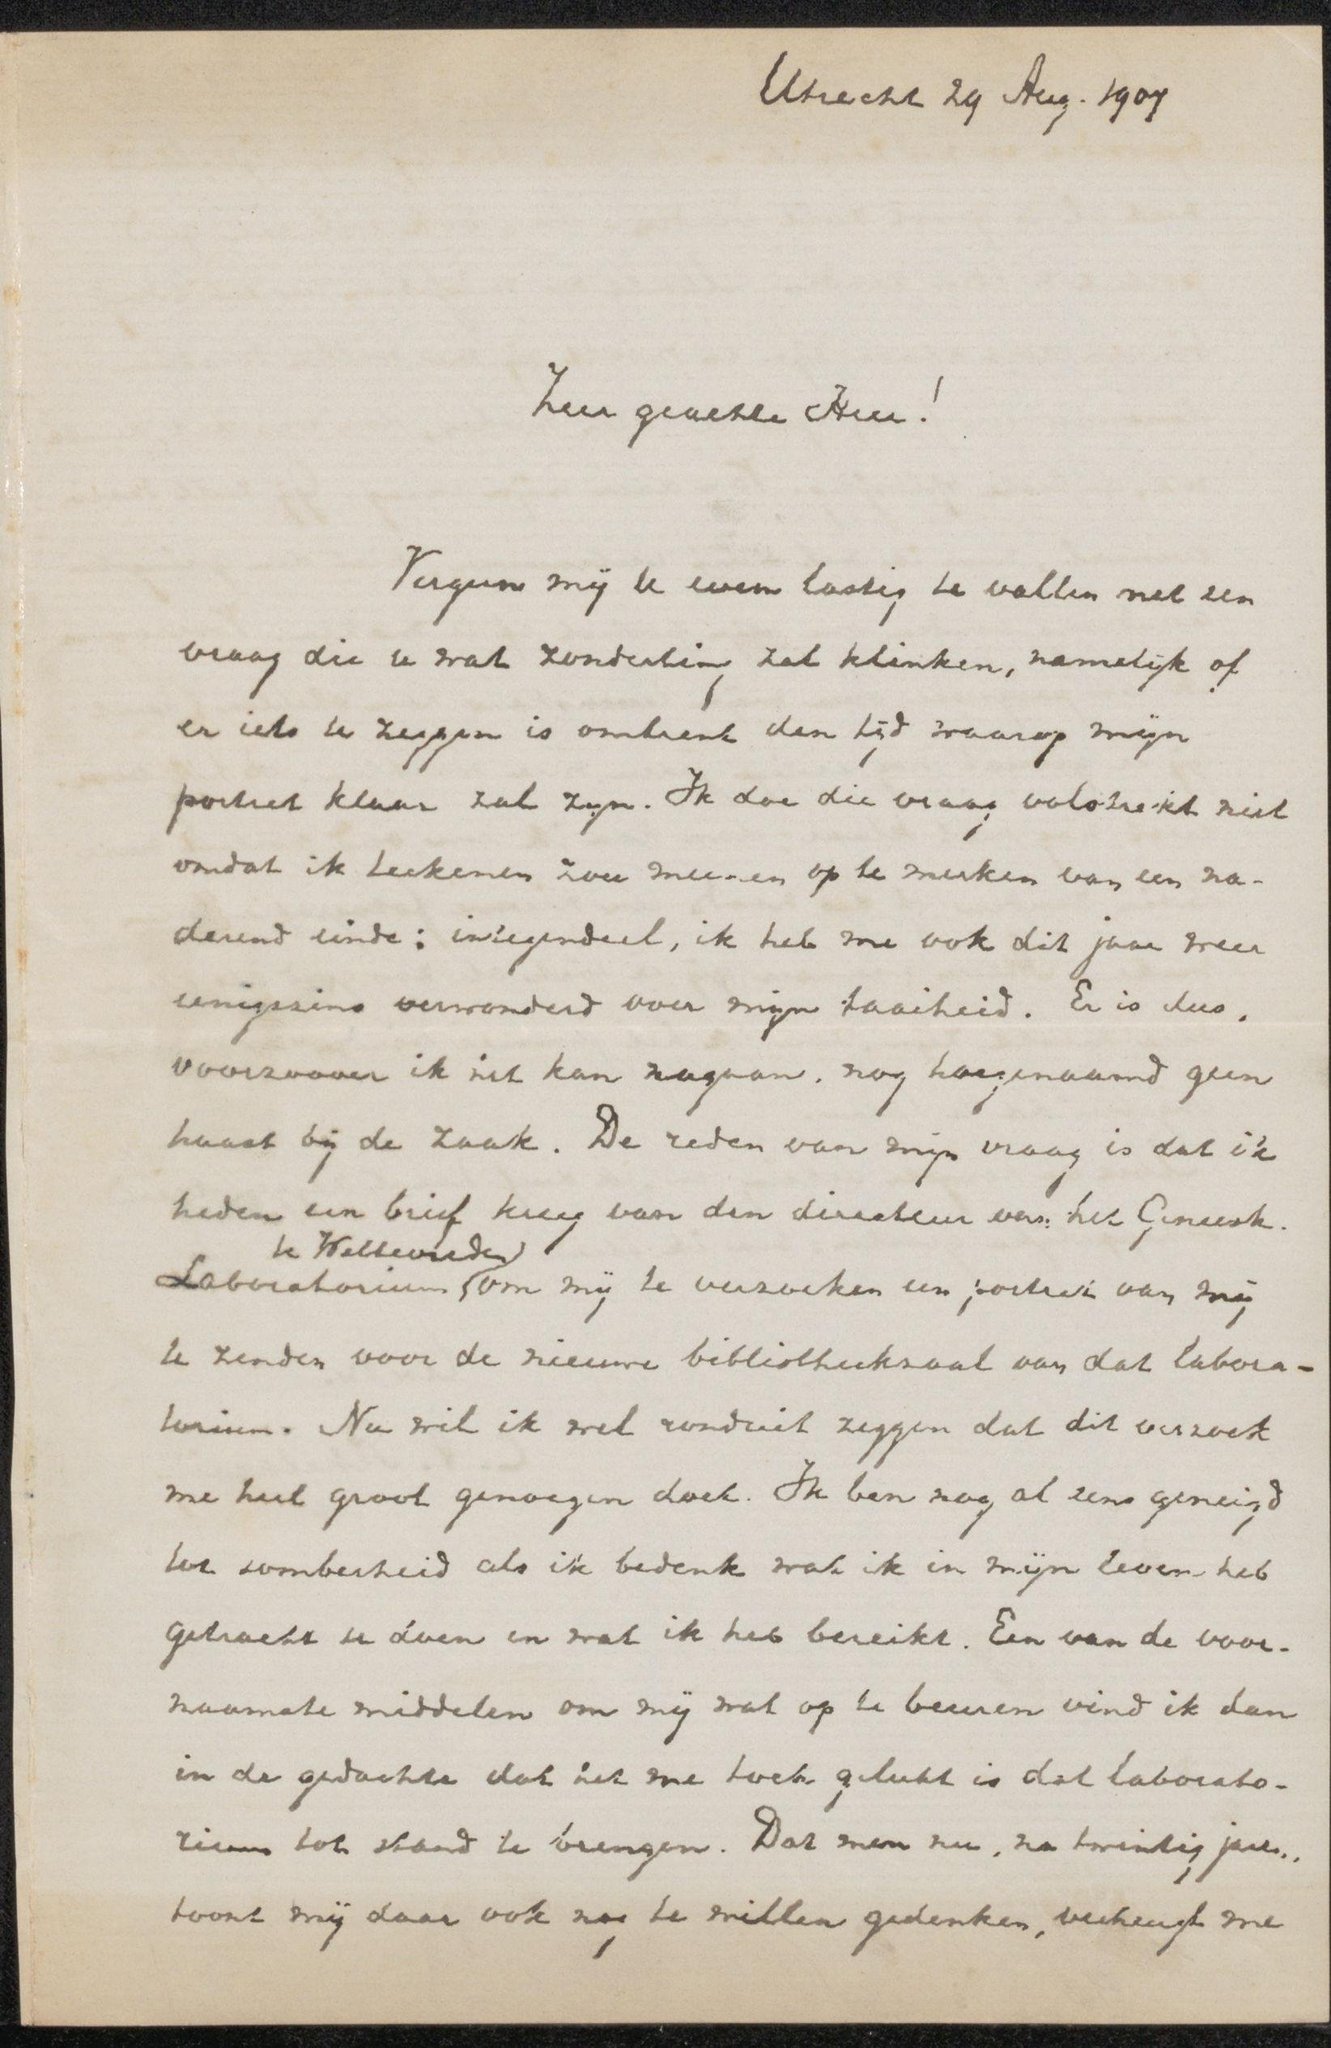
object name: letter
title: Brief aan Jan Veth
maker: cornelis adrianus pekelharing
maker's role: arts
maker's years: 1848-1922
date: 1907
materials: ink, paper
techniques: pen, writing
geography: utrecht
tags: painter, print maker, draughtsman, jan veth, photography, cinematography, painting (including book-illumination, miniature-painting), historical persons (portraits and scenes from the life)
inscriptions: collector's mark: ‘RPK’